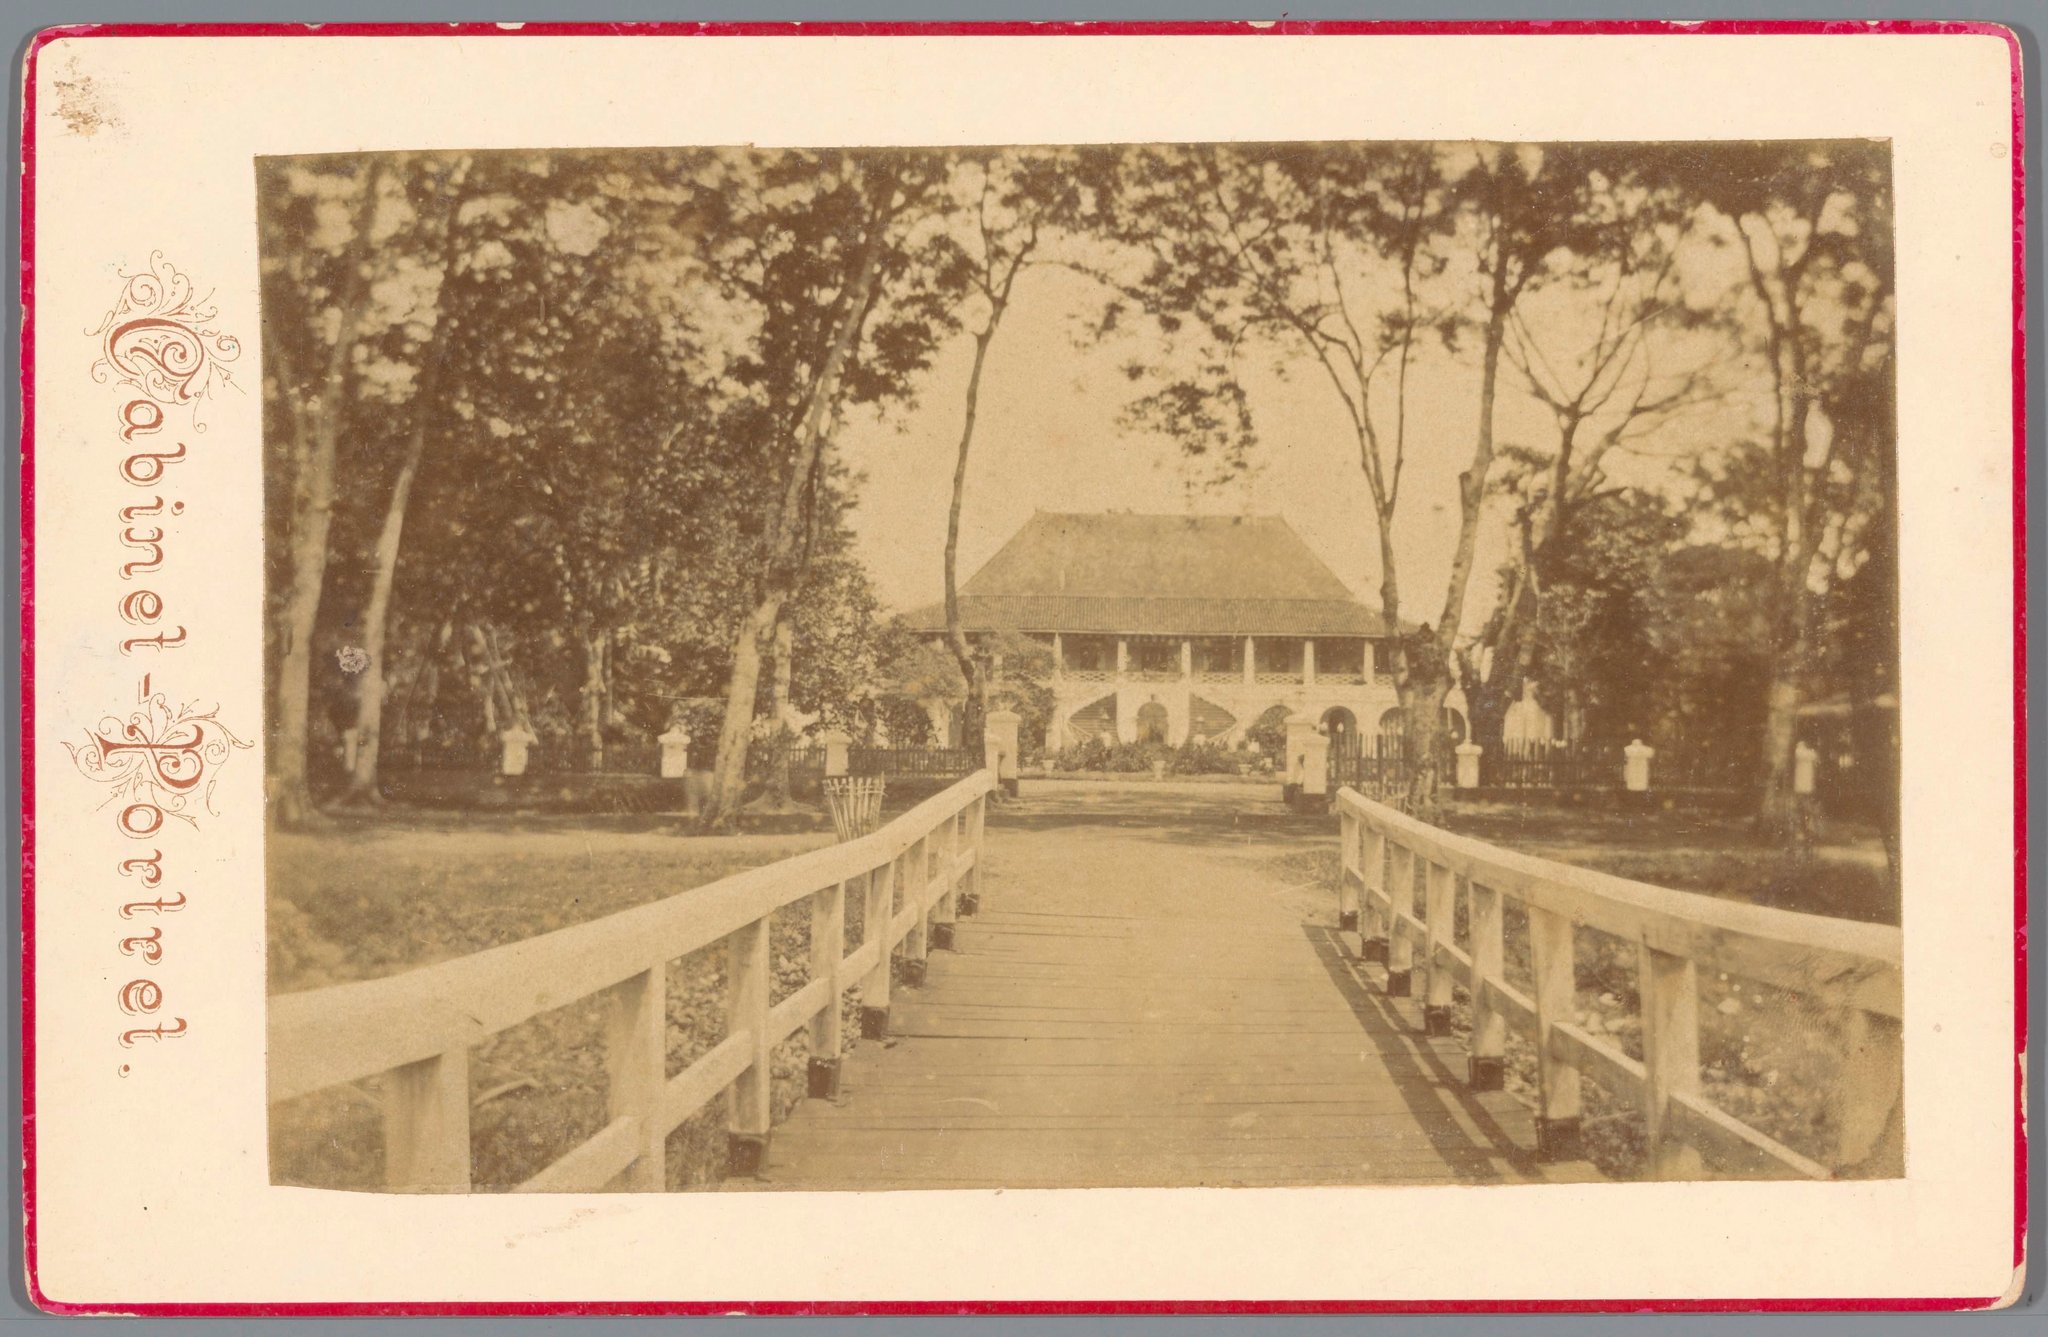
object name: cabinet photograph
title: Palembang. Residentiehuis, gezien van den daarvoor liggende steiger aan de rivier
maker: Anonymous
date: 1890-1910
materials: cardboard, paper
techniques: albumen print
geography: palembang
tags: country-house, palembang (city)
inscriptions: inscription: ‘Cabinet-Portret’